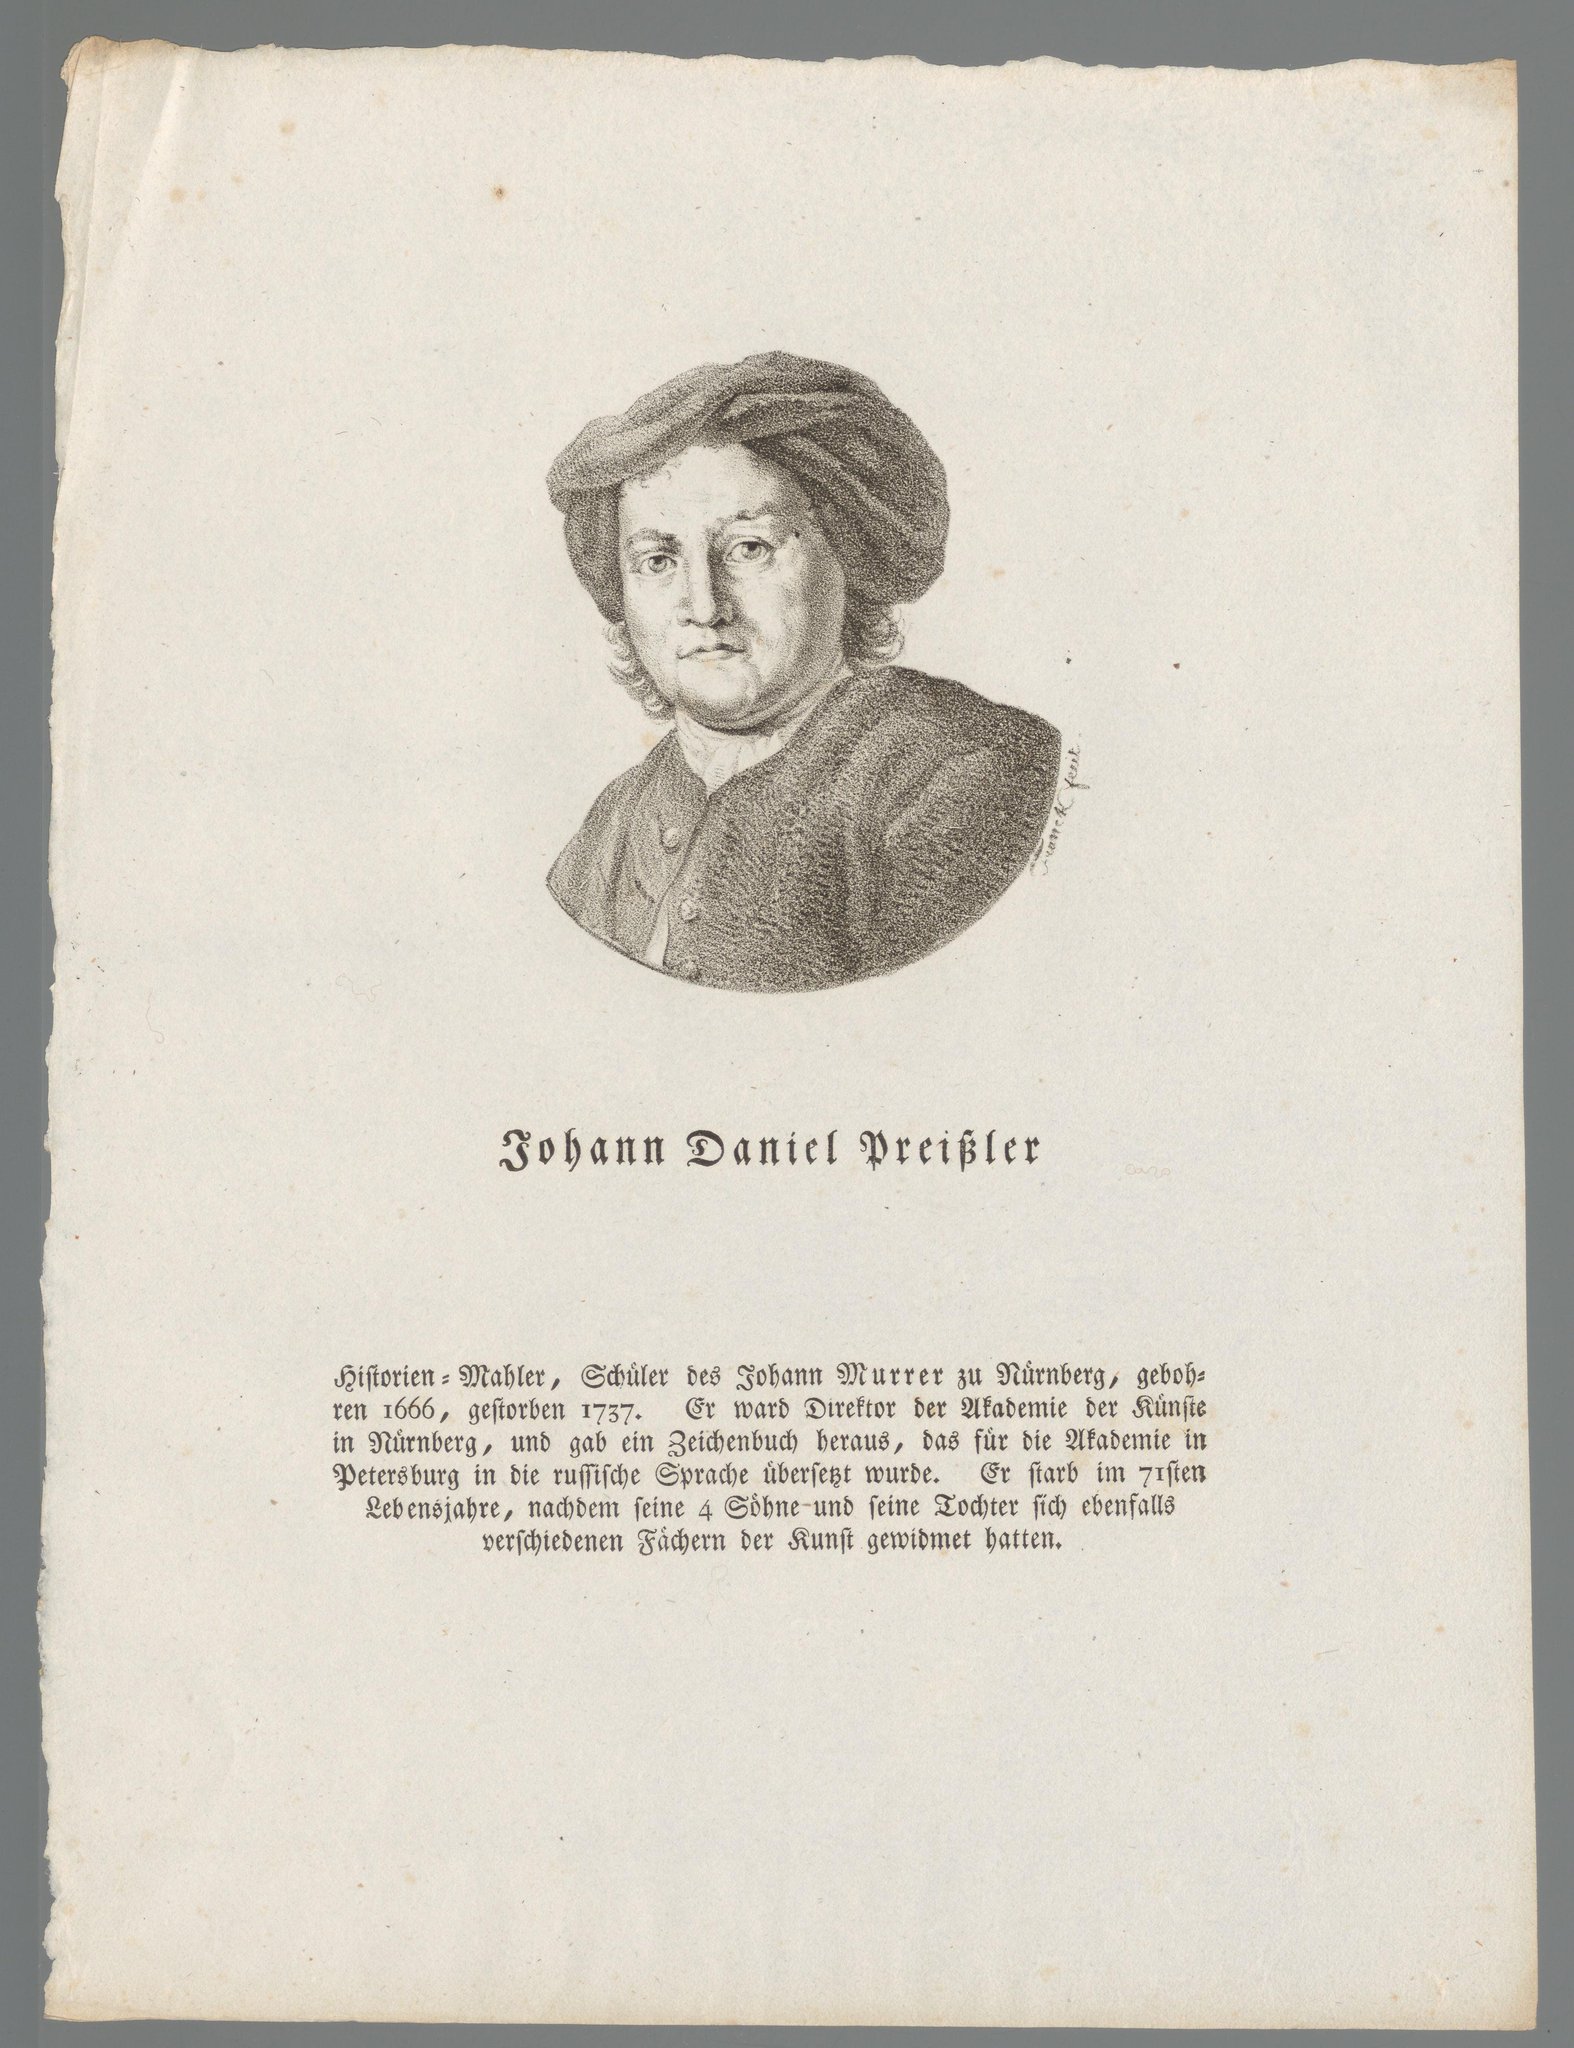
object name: print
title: Portret van Johann Daniel Preissler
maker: maximilian franck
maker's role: print maker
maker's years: 1780-1830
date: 1813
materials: paper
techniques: letterpress printing, lithograph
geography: munich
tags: painter, print maker, draughtsman, johann daniel preissler, historical persons, portrait, self-portrait of painter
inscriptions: collector's mark: Lugt 2228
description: Prent uit: Lindauer, Joseph. Deutsche Künstler-Gallerie. München: Maximilian Franck, 1813.